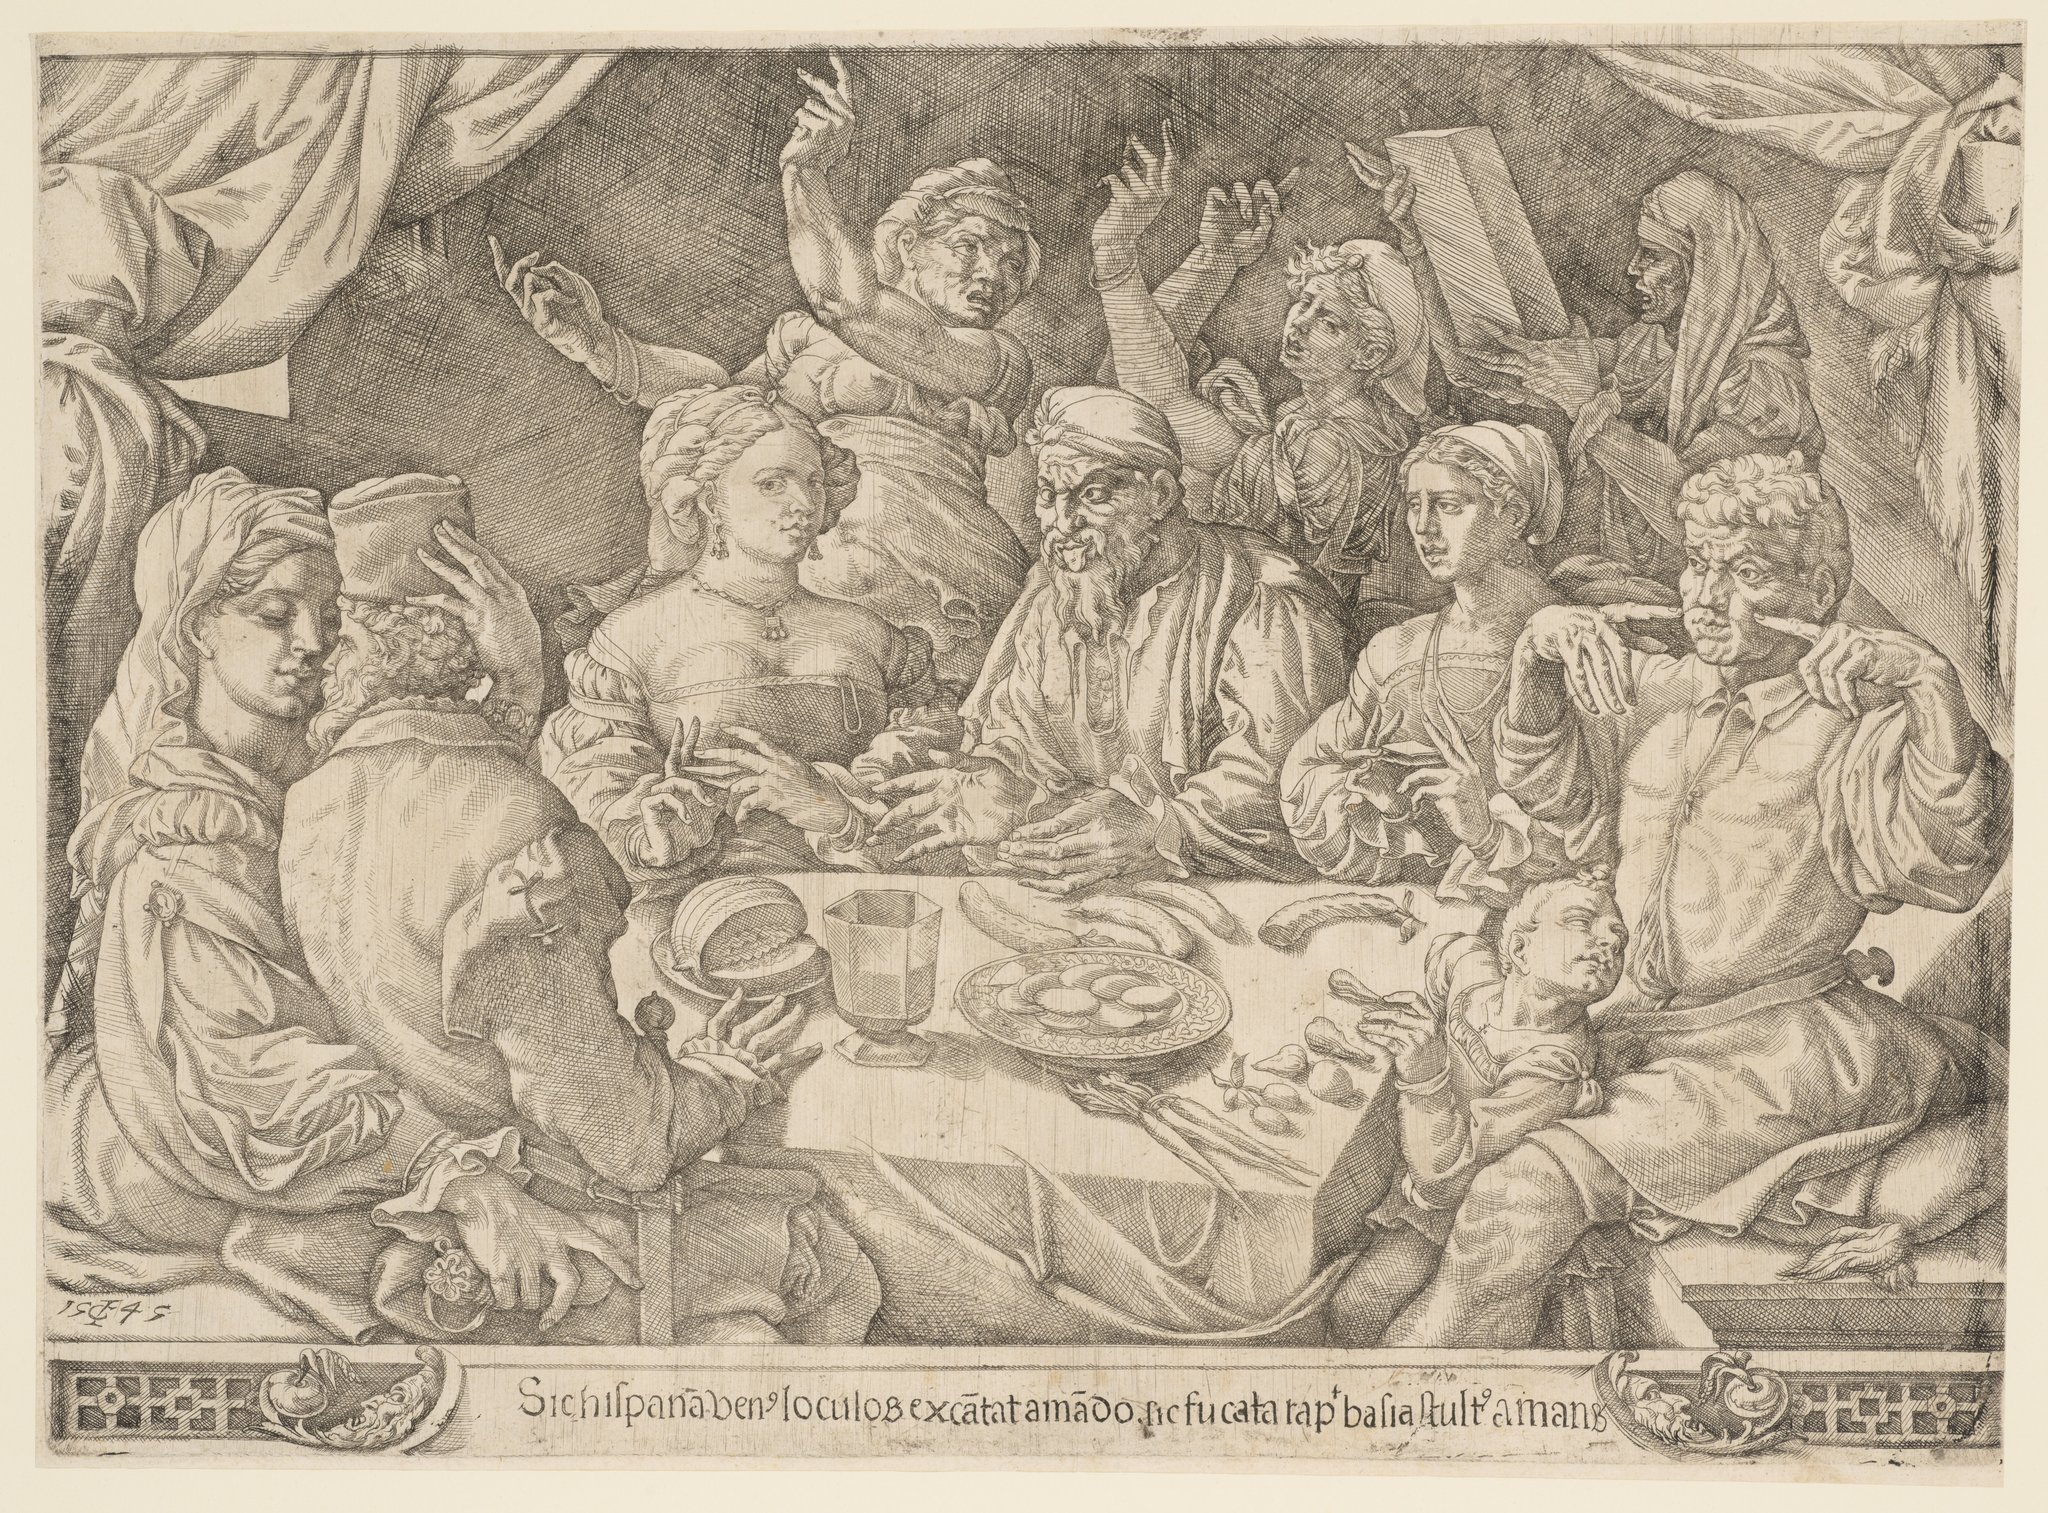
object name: print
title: The Spanish Banquet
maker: jan cornelisz vermeyen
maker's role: artist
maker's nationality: netherlandish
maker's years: 1504-1559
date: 1545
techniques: engraving, etching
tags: food,men,women,dining,banquets